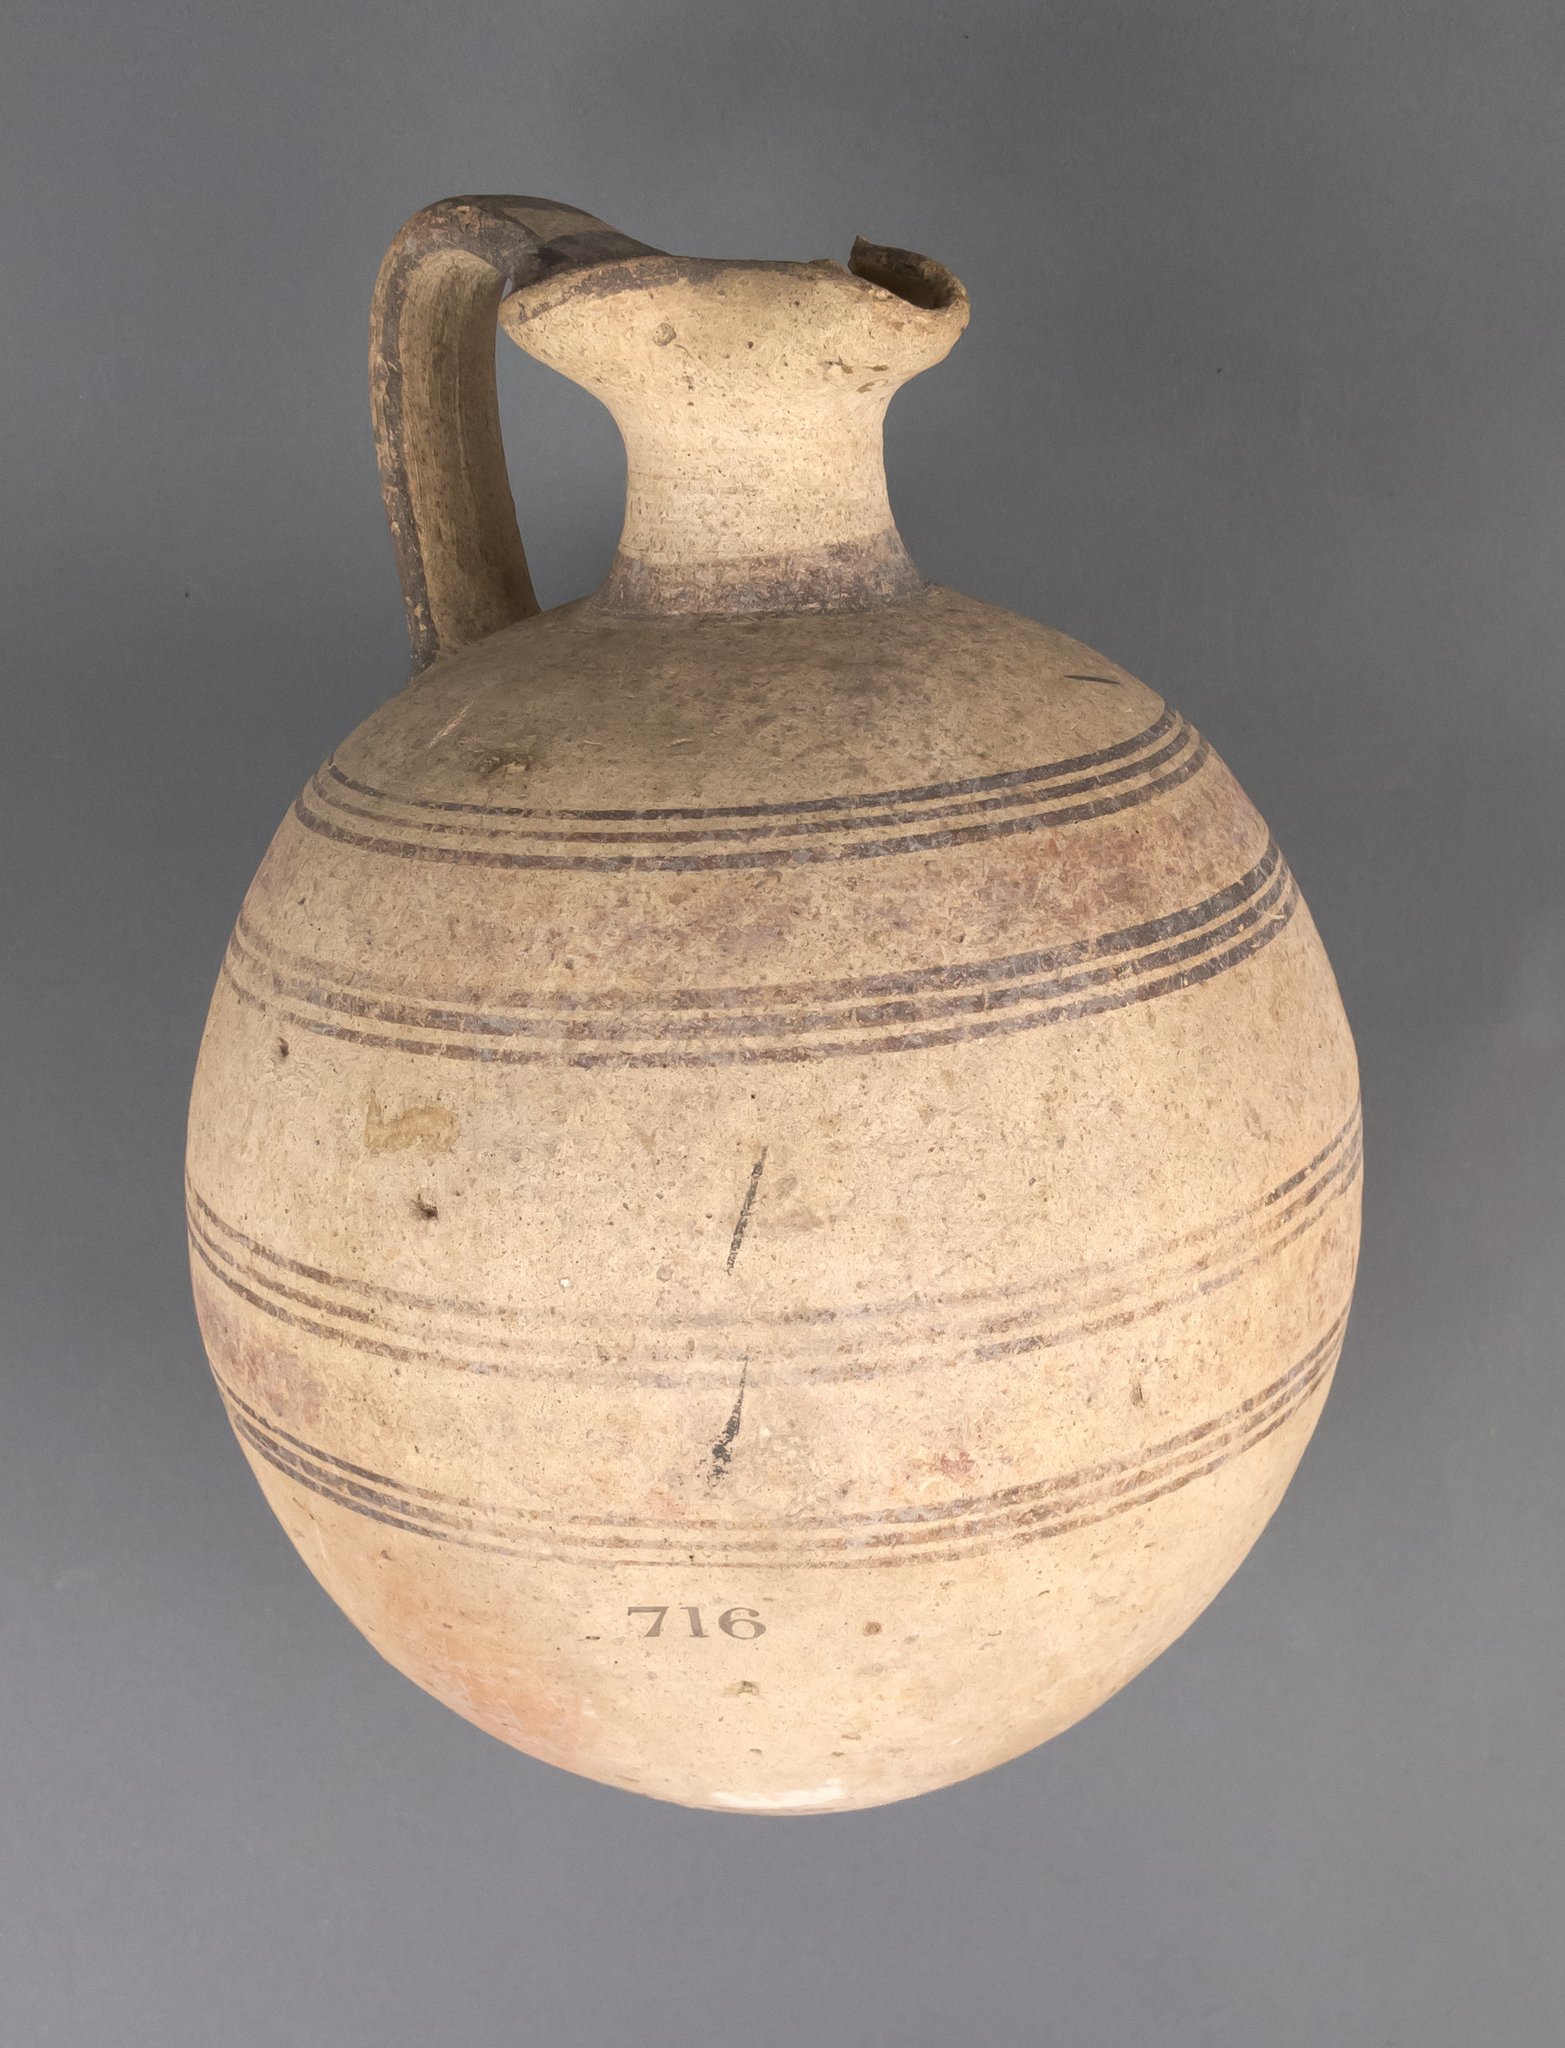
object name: oinochoe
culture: cypriot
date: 1050-900 BCE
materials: terracotta